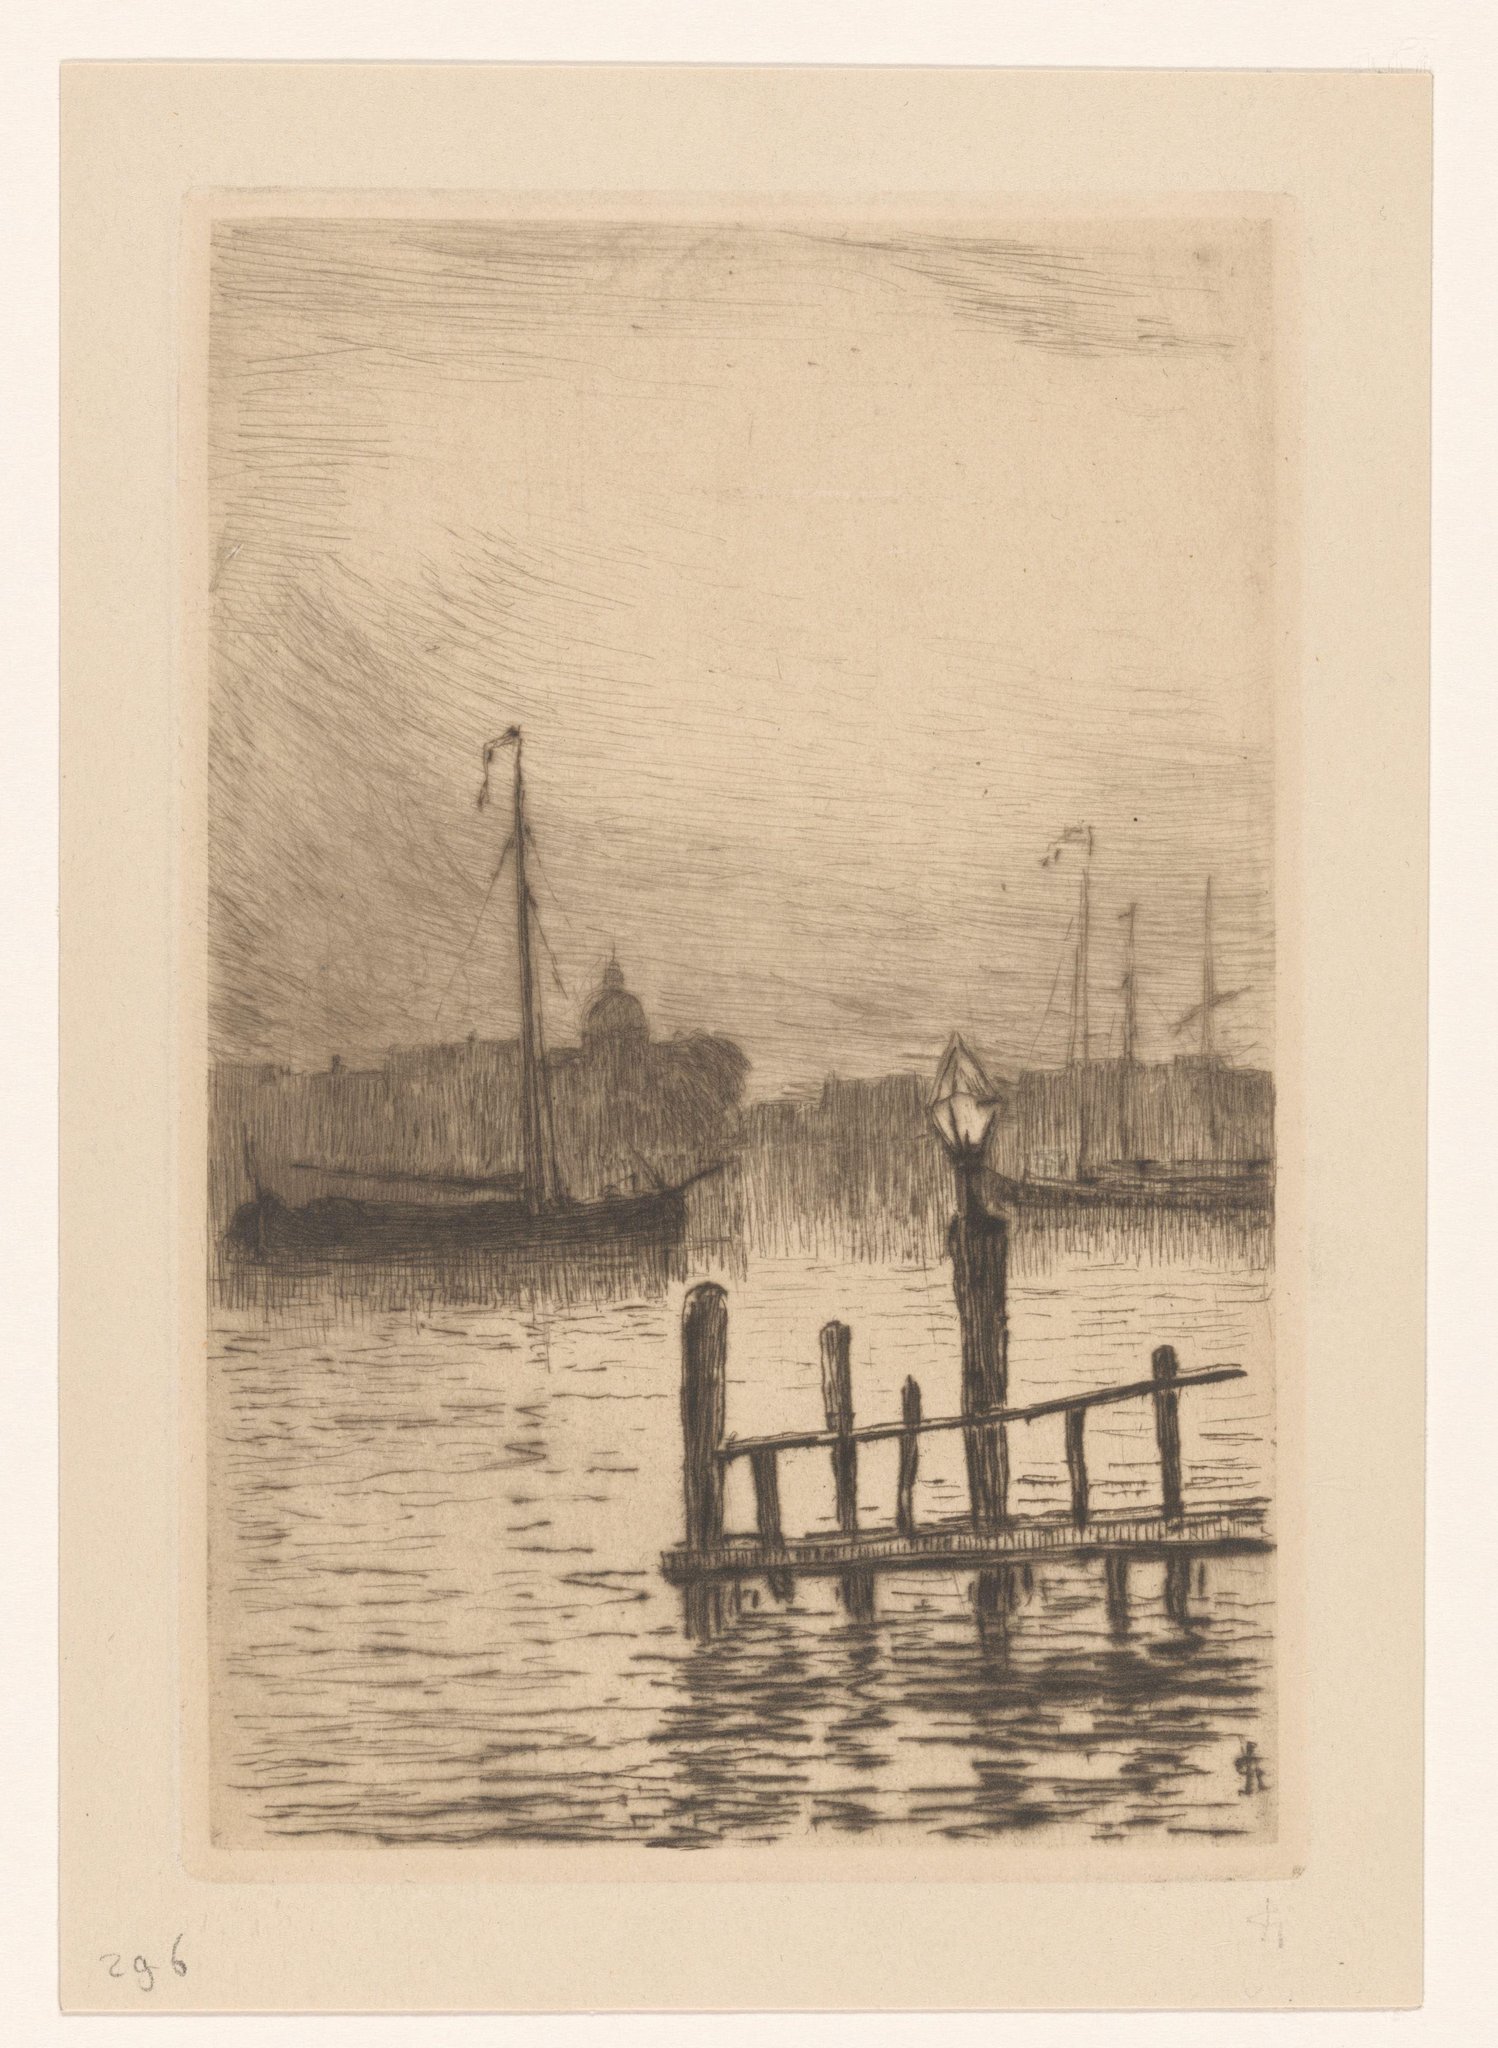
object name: print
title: Steiger in Papendrecht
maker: carel nicolaas storm van s-gravesande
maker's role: draughtsman, print maker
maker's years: 1841-1924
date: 1889-1902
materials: paper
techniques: drypoint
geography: netherlands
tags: pier, quay, wharf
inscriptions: number: ‘296’, collector's mark: Lugt 2228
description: Mogelijk vermeld in: Storm van 's-Gravesande, Charles. Catalogue des eaux-fortes et lithographies. New York: s.n., 1903, of in een onbekende latere uitgave van het manuscript. Vermoedelijk vermeld als catalogusnummer 296.